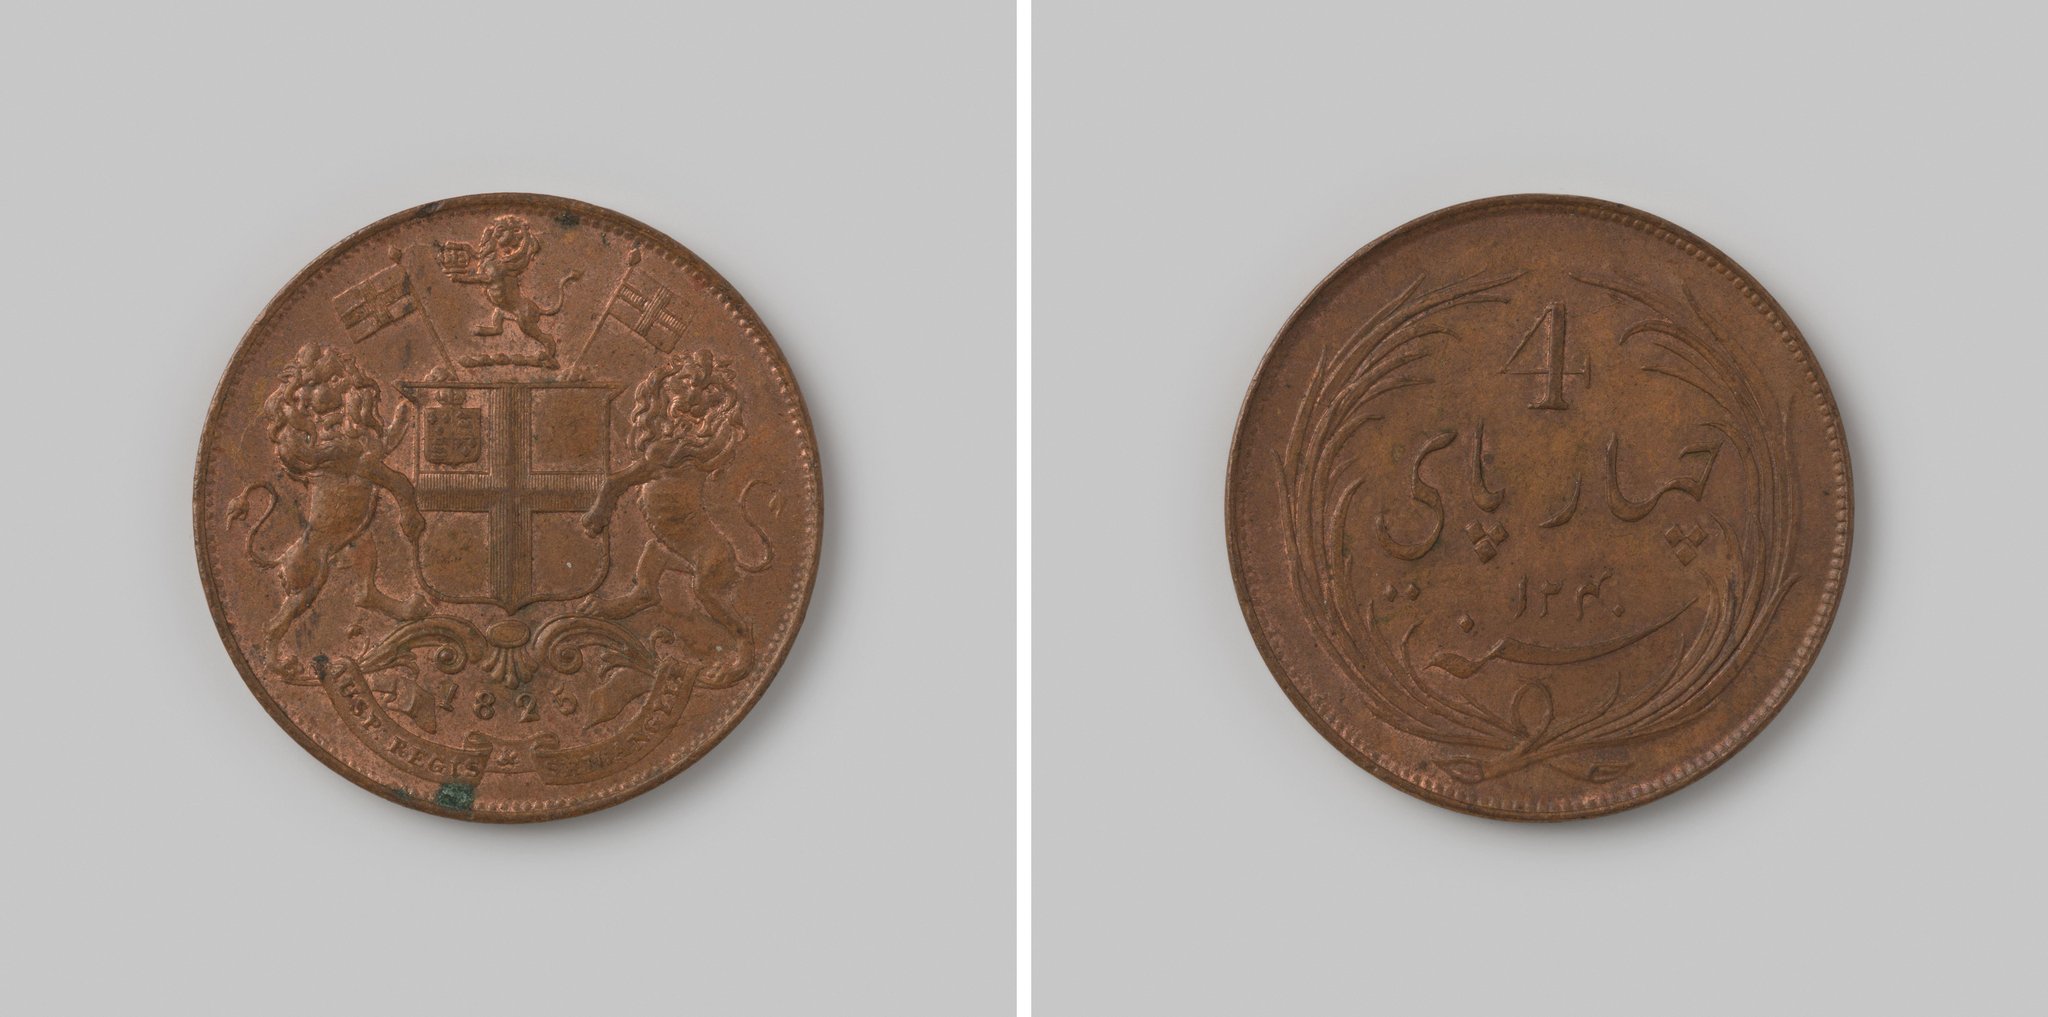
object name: coin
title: 4 pice voor Madras in India van de Engelse Oostindische Compagnie (EIC), 1825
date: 1825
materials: copper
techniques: striking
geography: london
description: Koperen munt. Voorzijde: door twee op banderol, waarin opschrift, staande leeuwen met pijl, waaraan vlag, in de klauw, gehouden wapenschild van de EIC, waarboven helmteken. Tussen wapenschild en banderol jaartal. Keerzijde: tussen twee samengebonden takken in twee regels waarde-aanduiding: 4 pice, waaronder jaartal: 1240. Gladde rand.